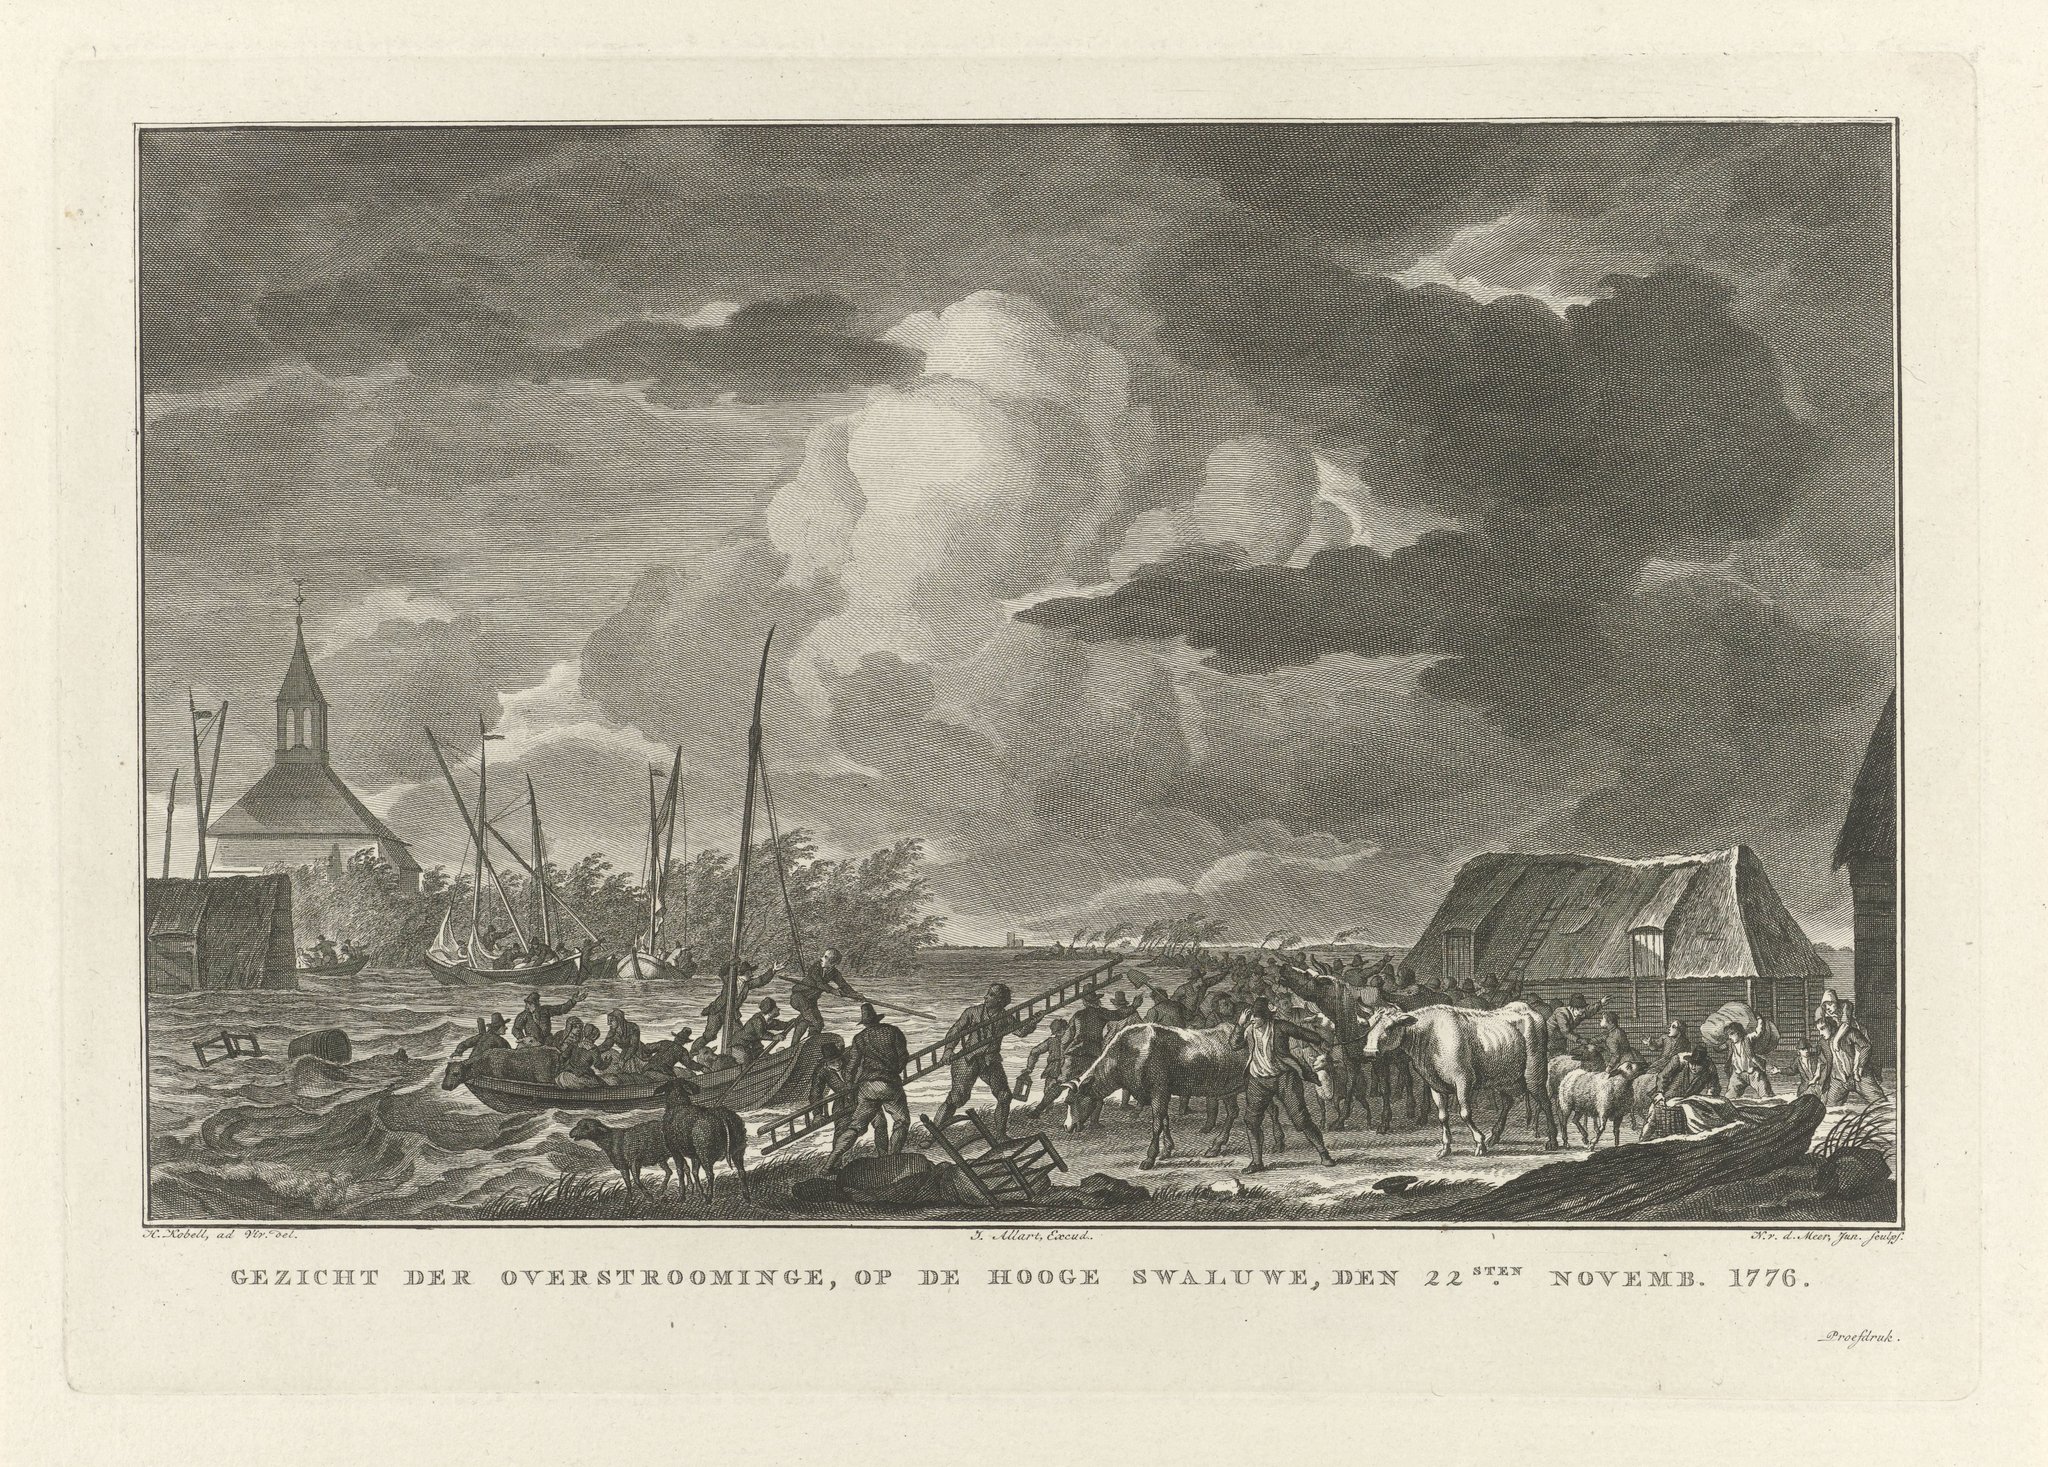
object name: print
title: Gezicht der overstroominge, op de Hooge Swaluwe, den 22sten novemb. 1776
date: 1778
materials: paper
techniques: etching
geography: amsterdam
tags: rescue work during a flood, sailing-ship, sailing-boat, flood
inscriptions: collector's mark: Lugt 2228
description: Overstroming bij Hooge Zwaluwe op 22 november 1776. Op de voorgrond worden mensen en dieren op het droge gebracht. Zeilboten varen met mensen en vee aan boord. Op de achtergrond een kerk.